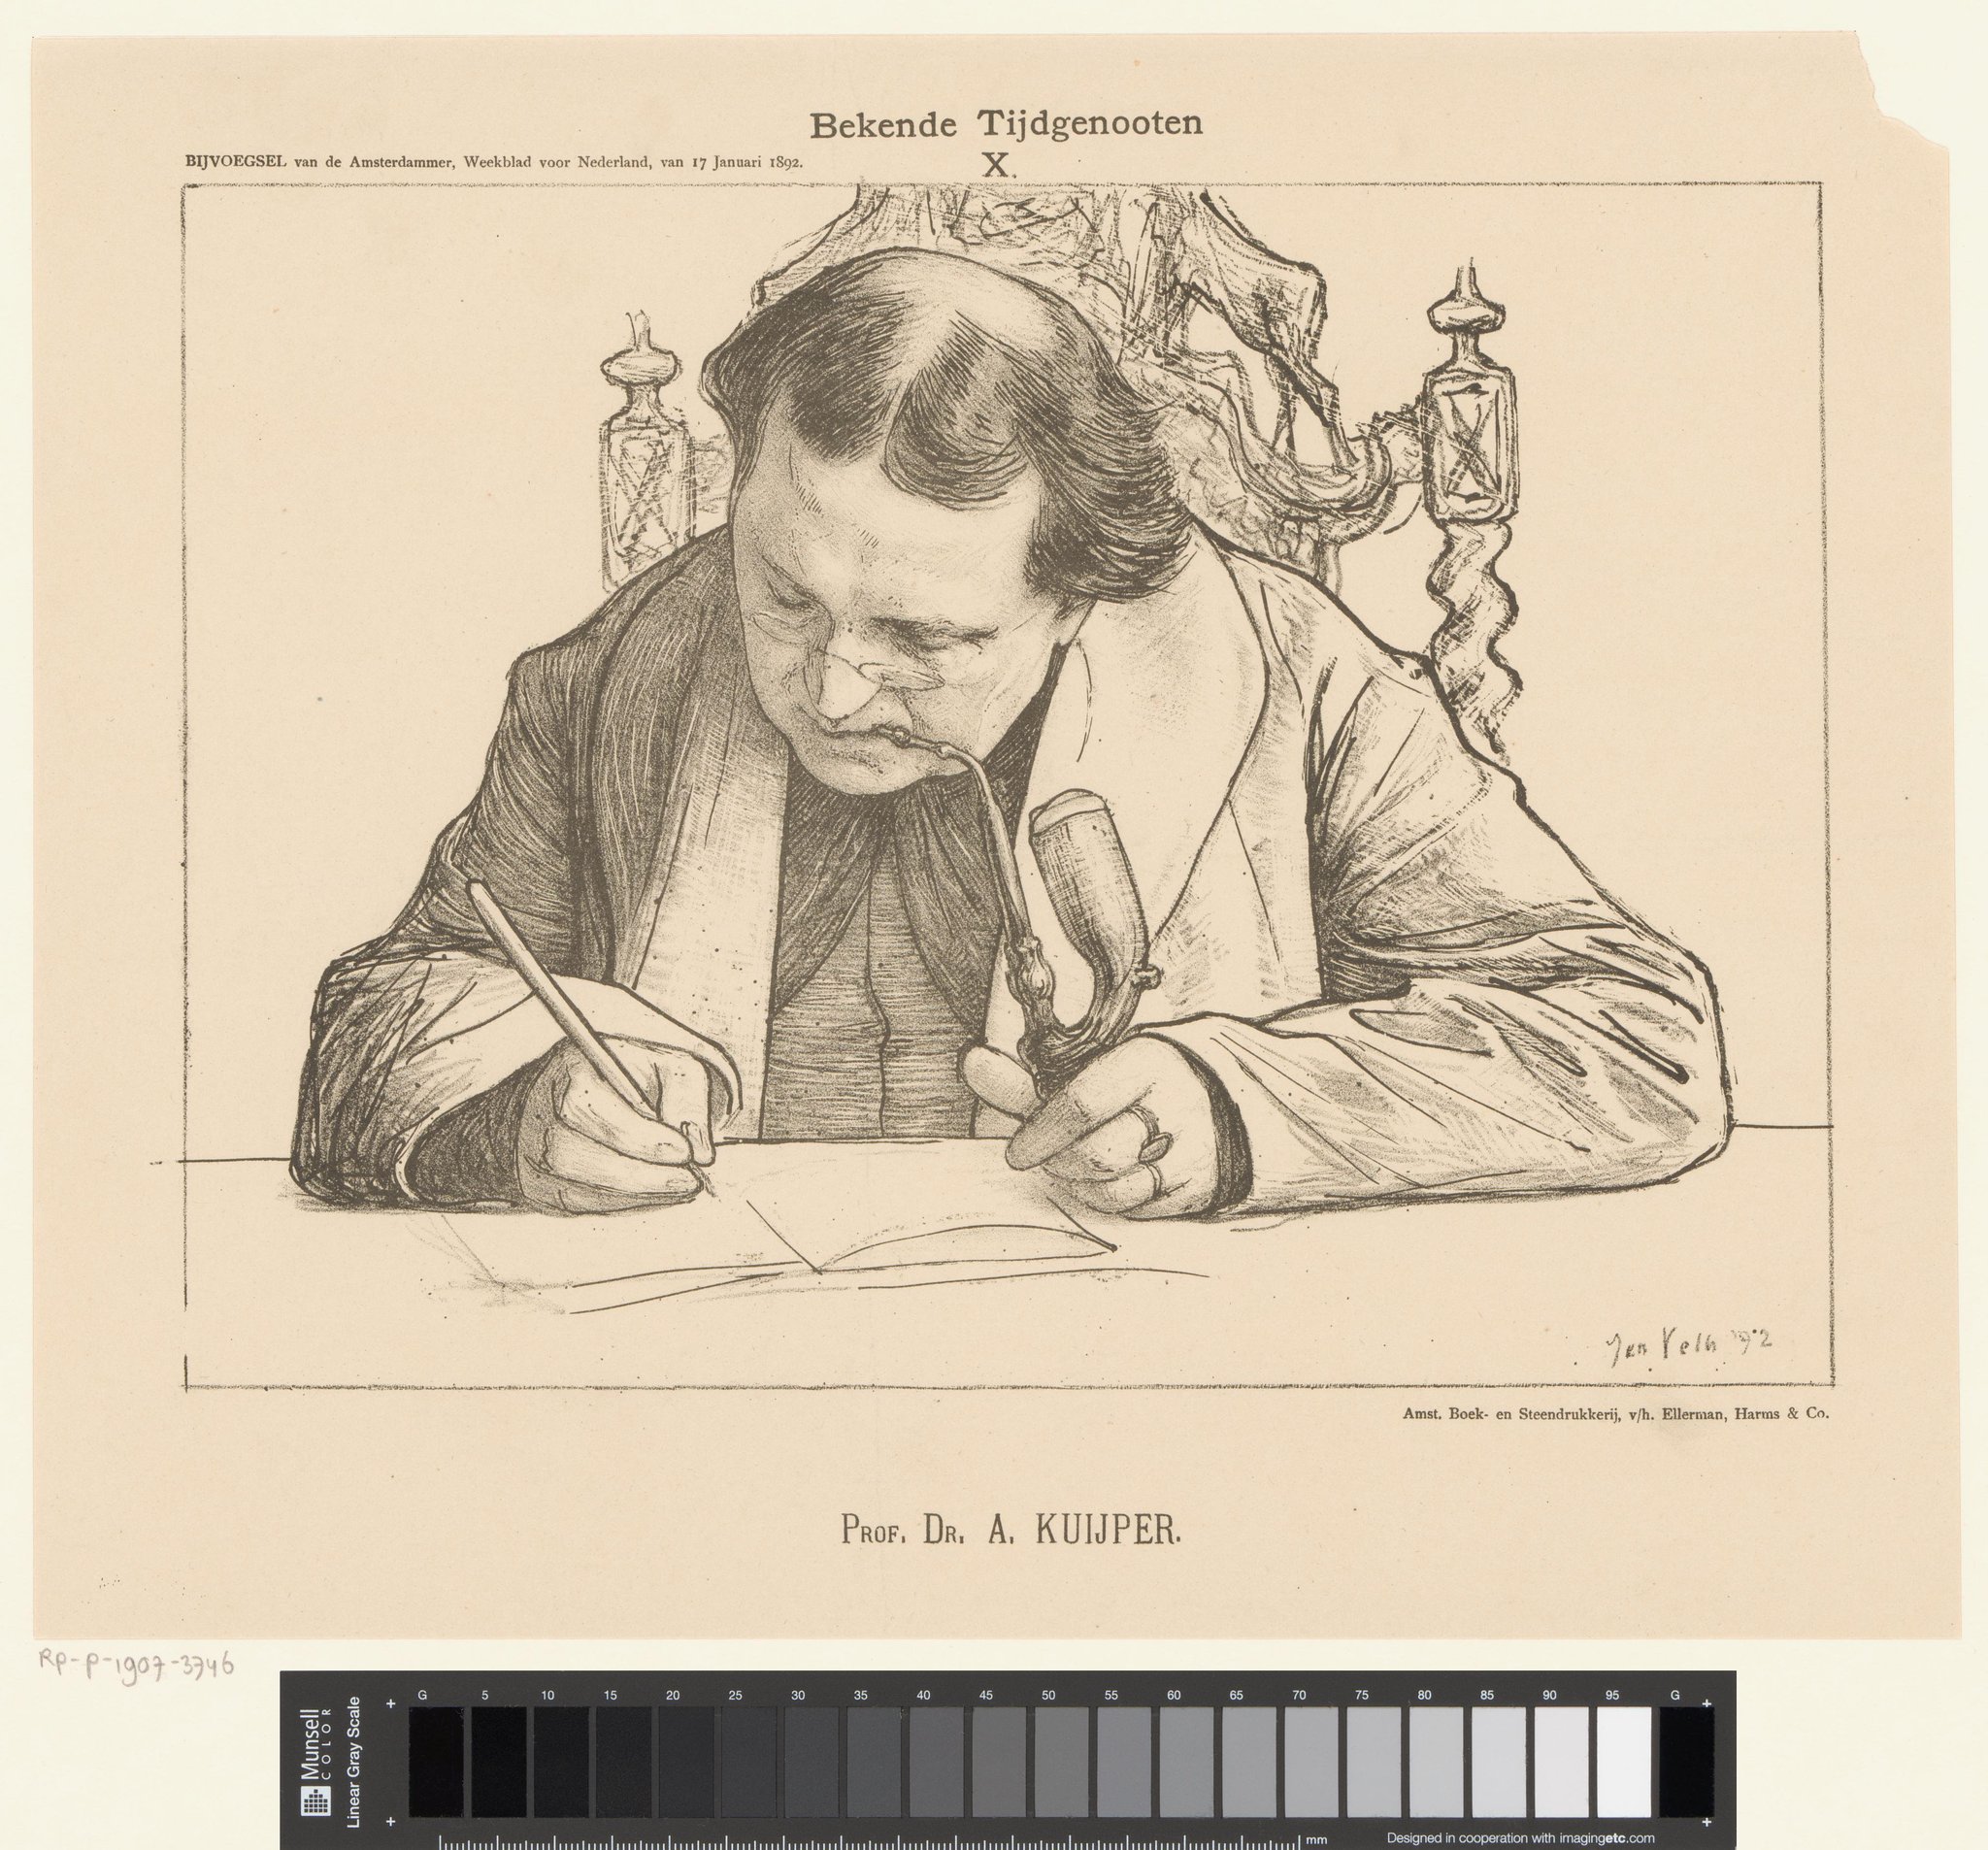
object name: print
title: Portret van schrijvende Abraham Kuyper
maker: jan veth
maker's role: designer, draughtsman, painter, print maker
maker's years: 1864-1925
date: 1892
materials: paper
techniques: lithograph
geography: amsterdam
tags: the hague, abraham kuyper, writing tools, pipe ~ tobacco, historical persons (+ (full) bust portrait)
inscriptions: collector's mark: Lugt 2228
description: Deze prent werd uitgegeven bij De Amsterdammer op 17 januari 1892.